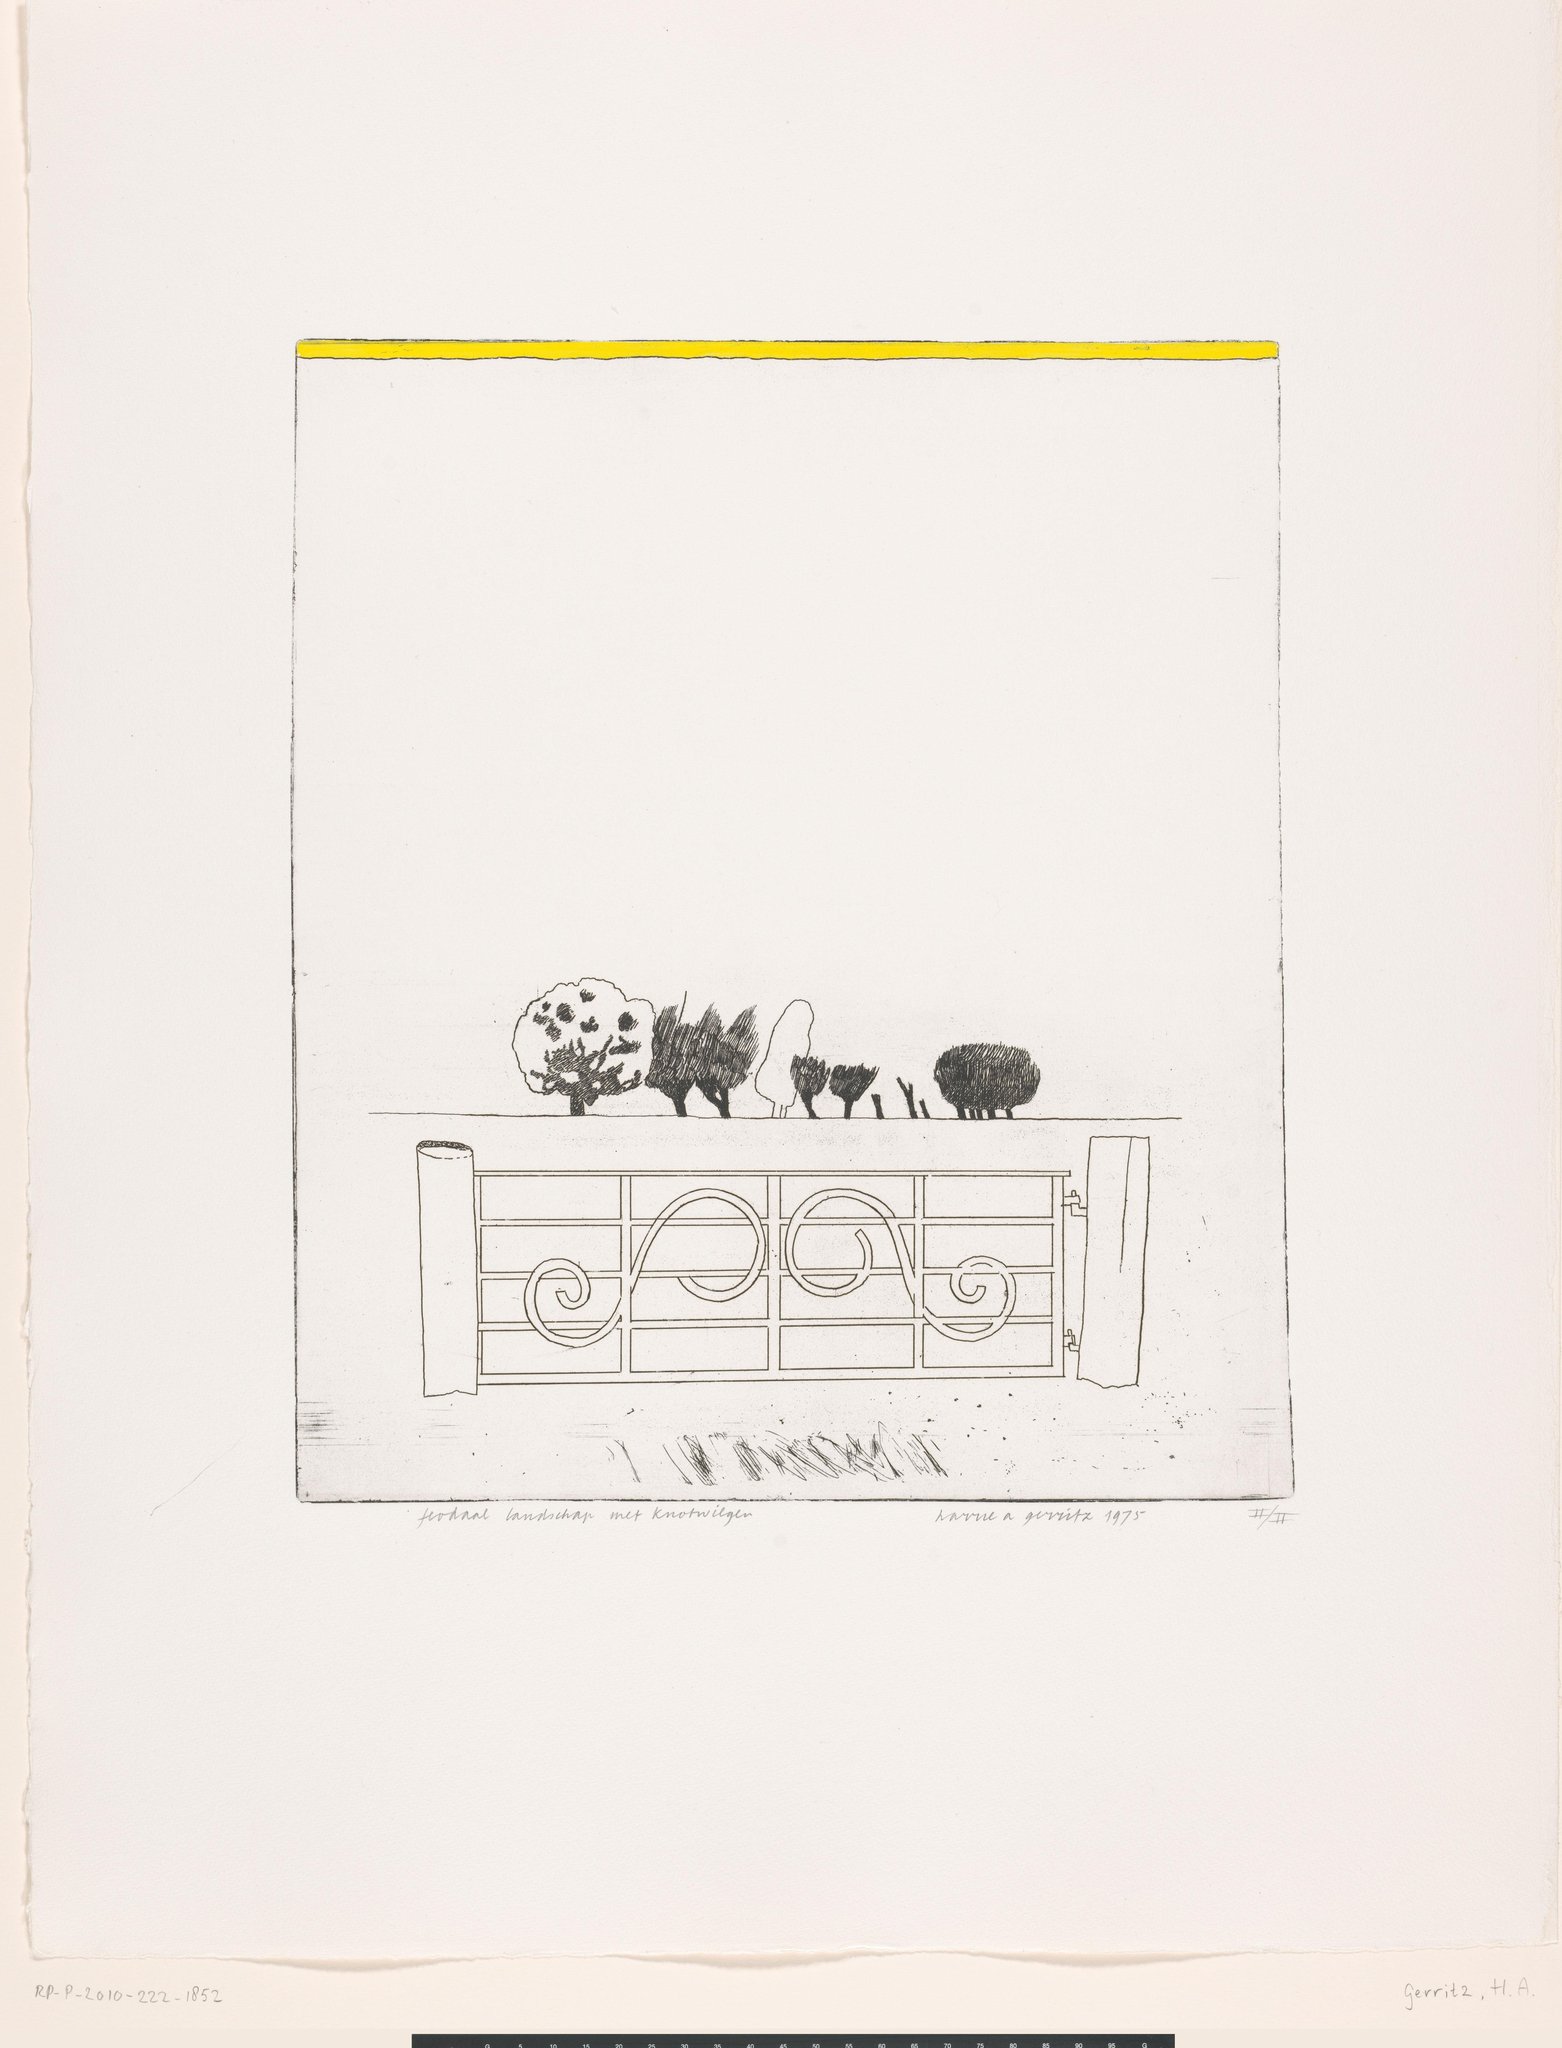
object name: print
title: Feodaal landschap met knotwilgen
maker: harrie a. gerritz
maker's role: draughtsman, painter, print maker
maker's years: 1940-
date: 1975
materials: paper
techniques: etching, hand coloring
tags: trees, landscapes in the temperate zone, receiver, fence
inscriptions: inscription: ‘PC’, collector's mark: Lugt 2228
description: Bomen aan een horizon. Vooraan een hek met siersmeedwerk.